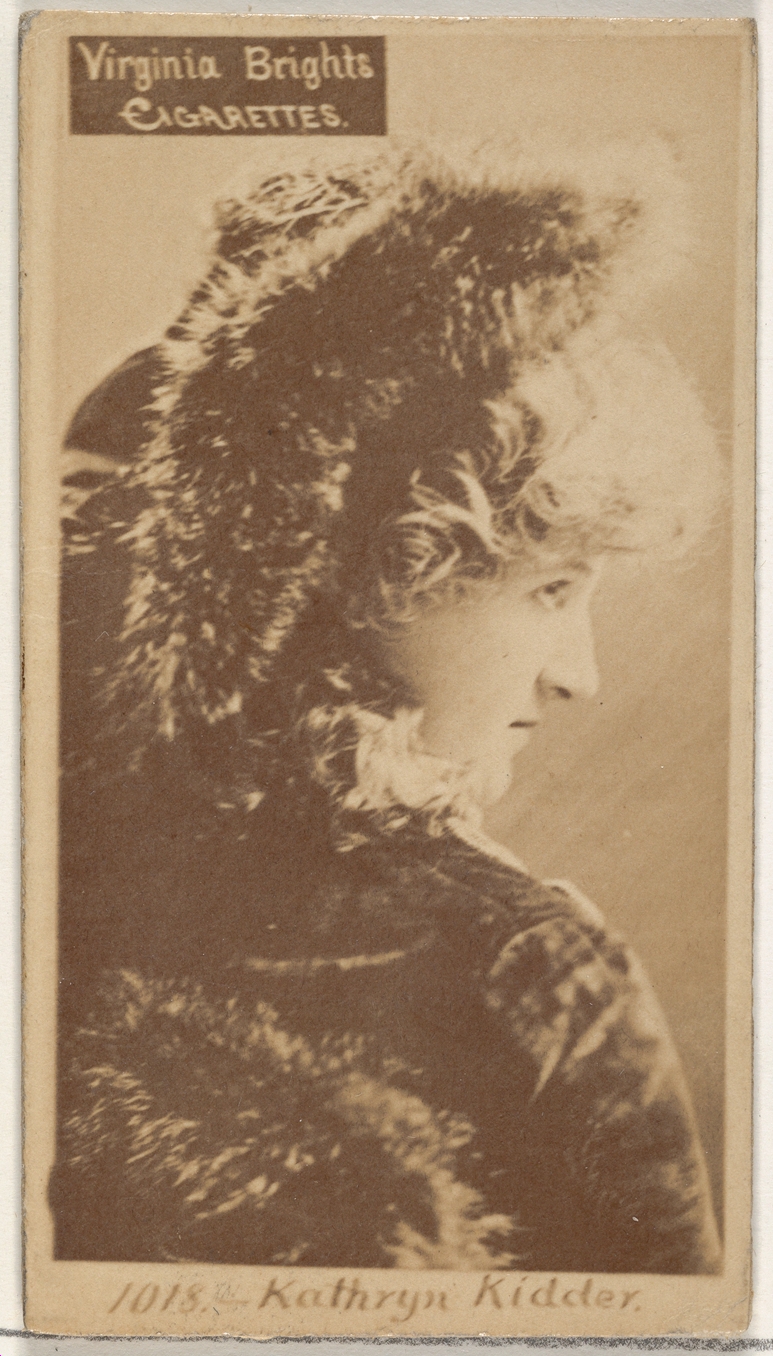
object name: photograph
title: Card 1018, Kathryn Kidder, from the Actors and Actresses series (N45, Type 2) for Virginia Brights Cigarettes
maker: allen & ginter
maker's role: publisher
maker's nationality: american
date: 1888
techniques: albumen silver print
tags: women,actresses